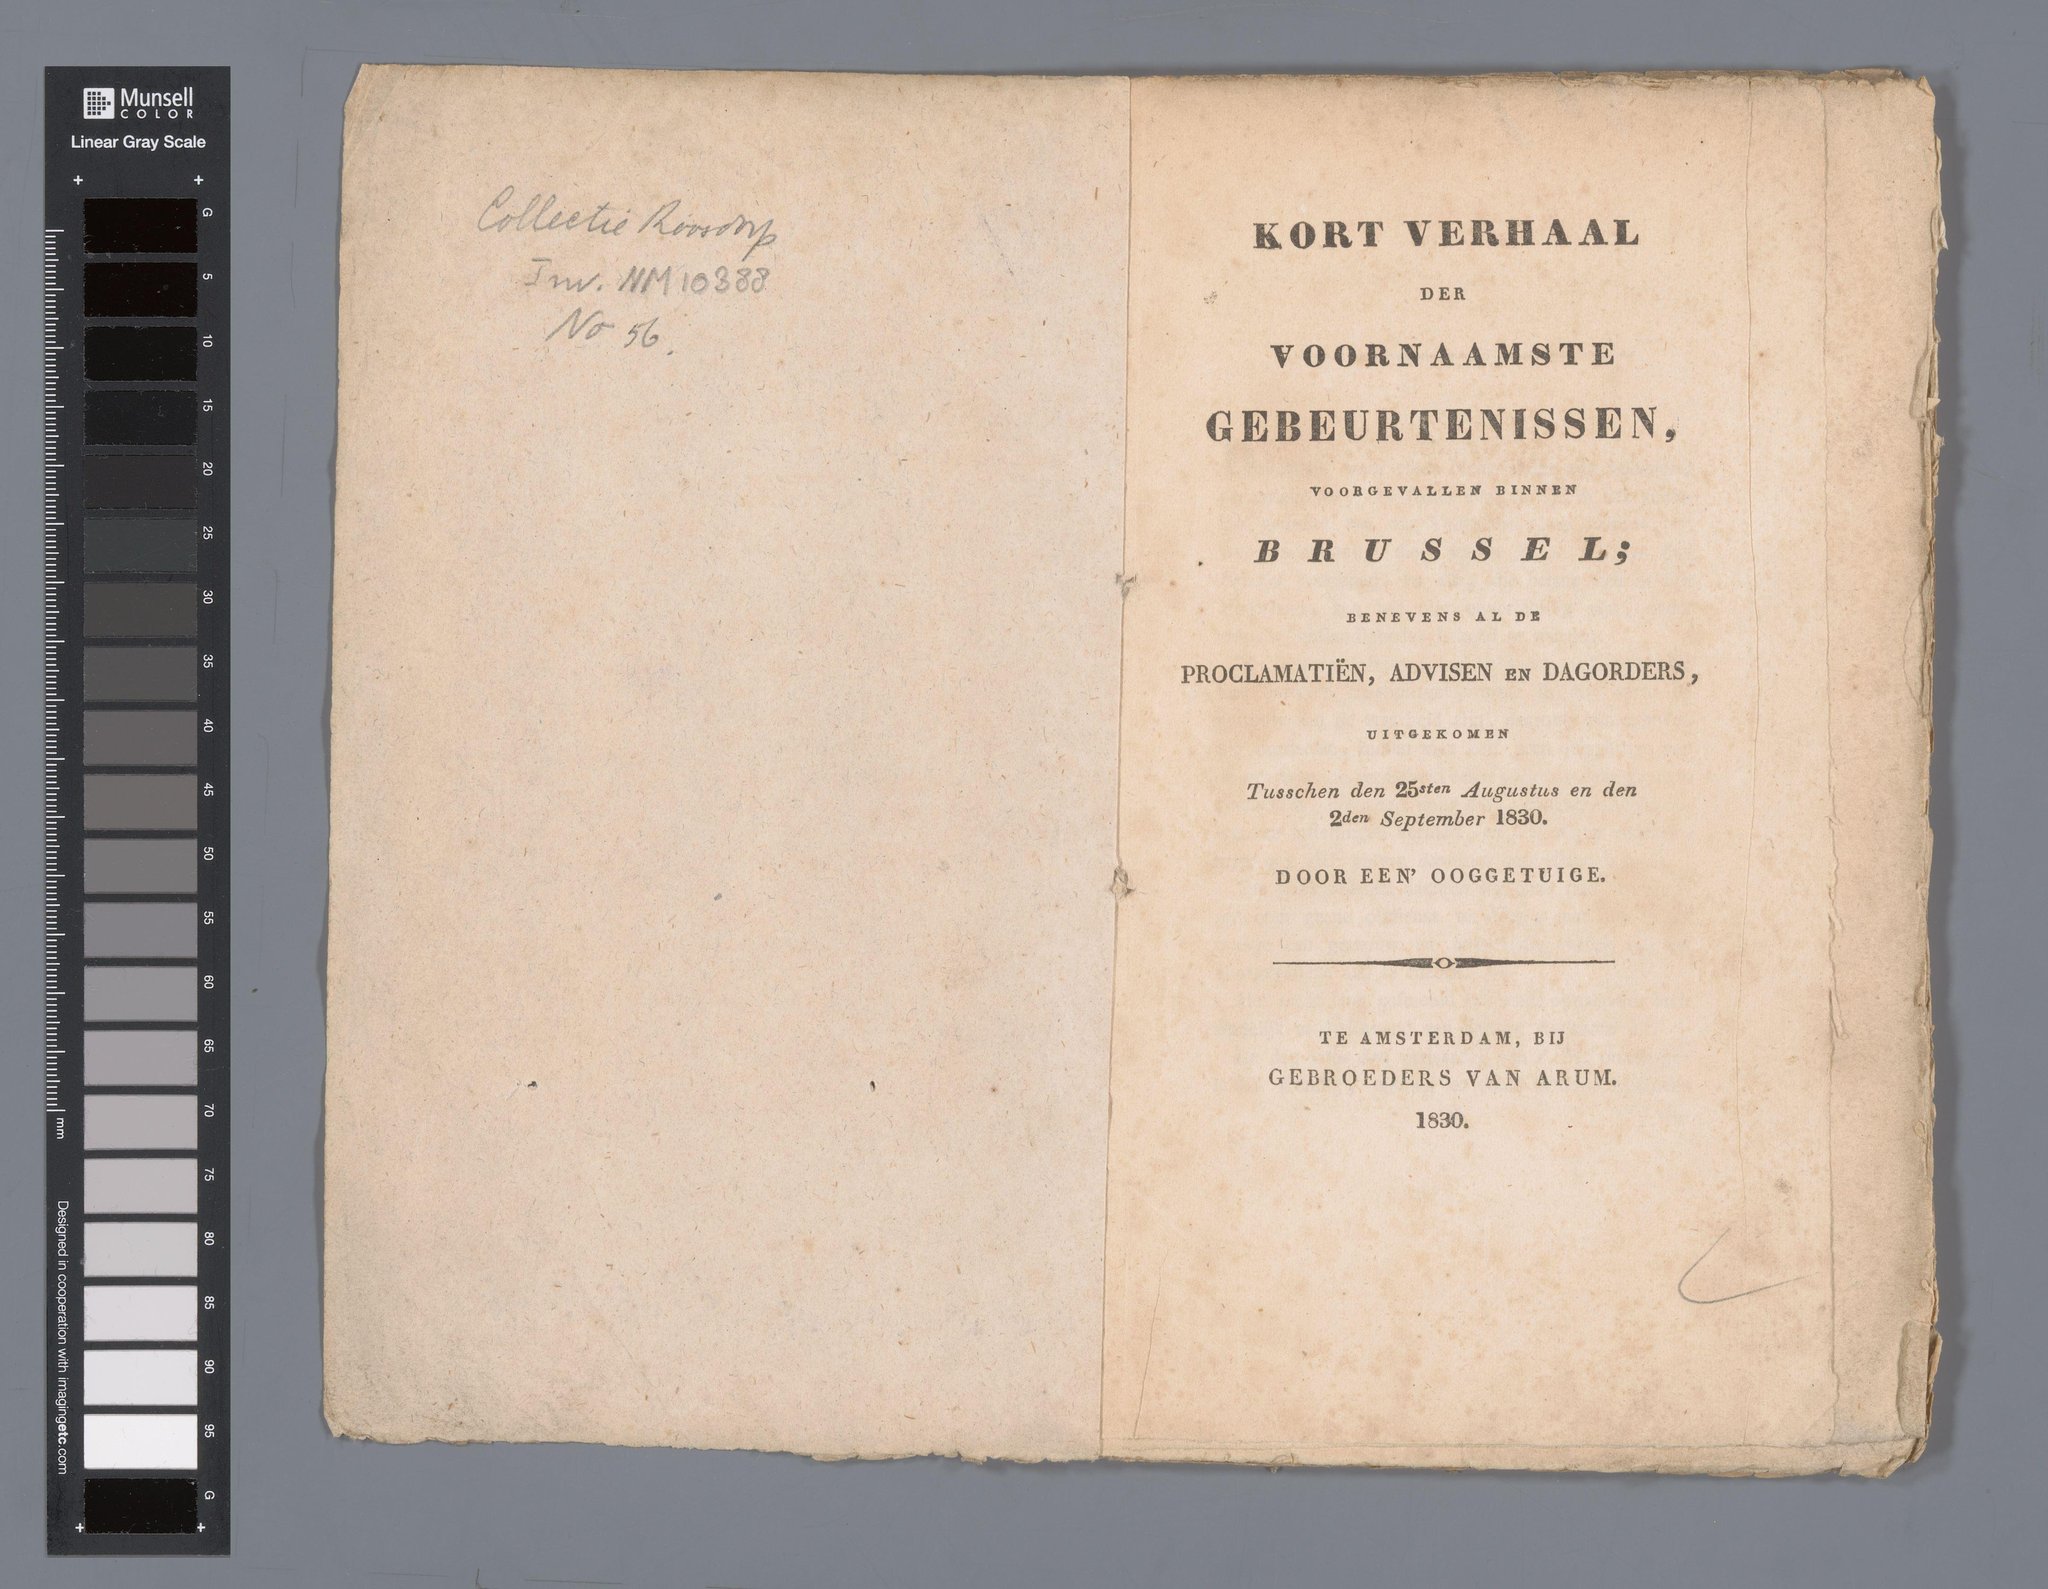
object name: book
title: Kort verhaal der voornaamste gebeurtenissen, voorgevallen binnen Brussel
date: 1830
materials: paper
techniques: bookbinding, printing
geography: amsterdam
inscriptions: date